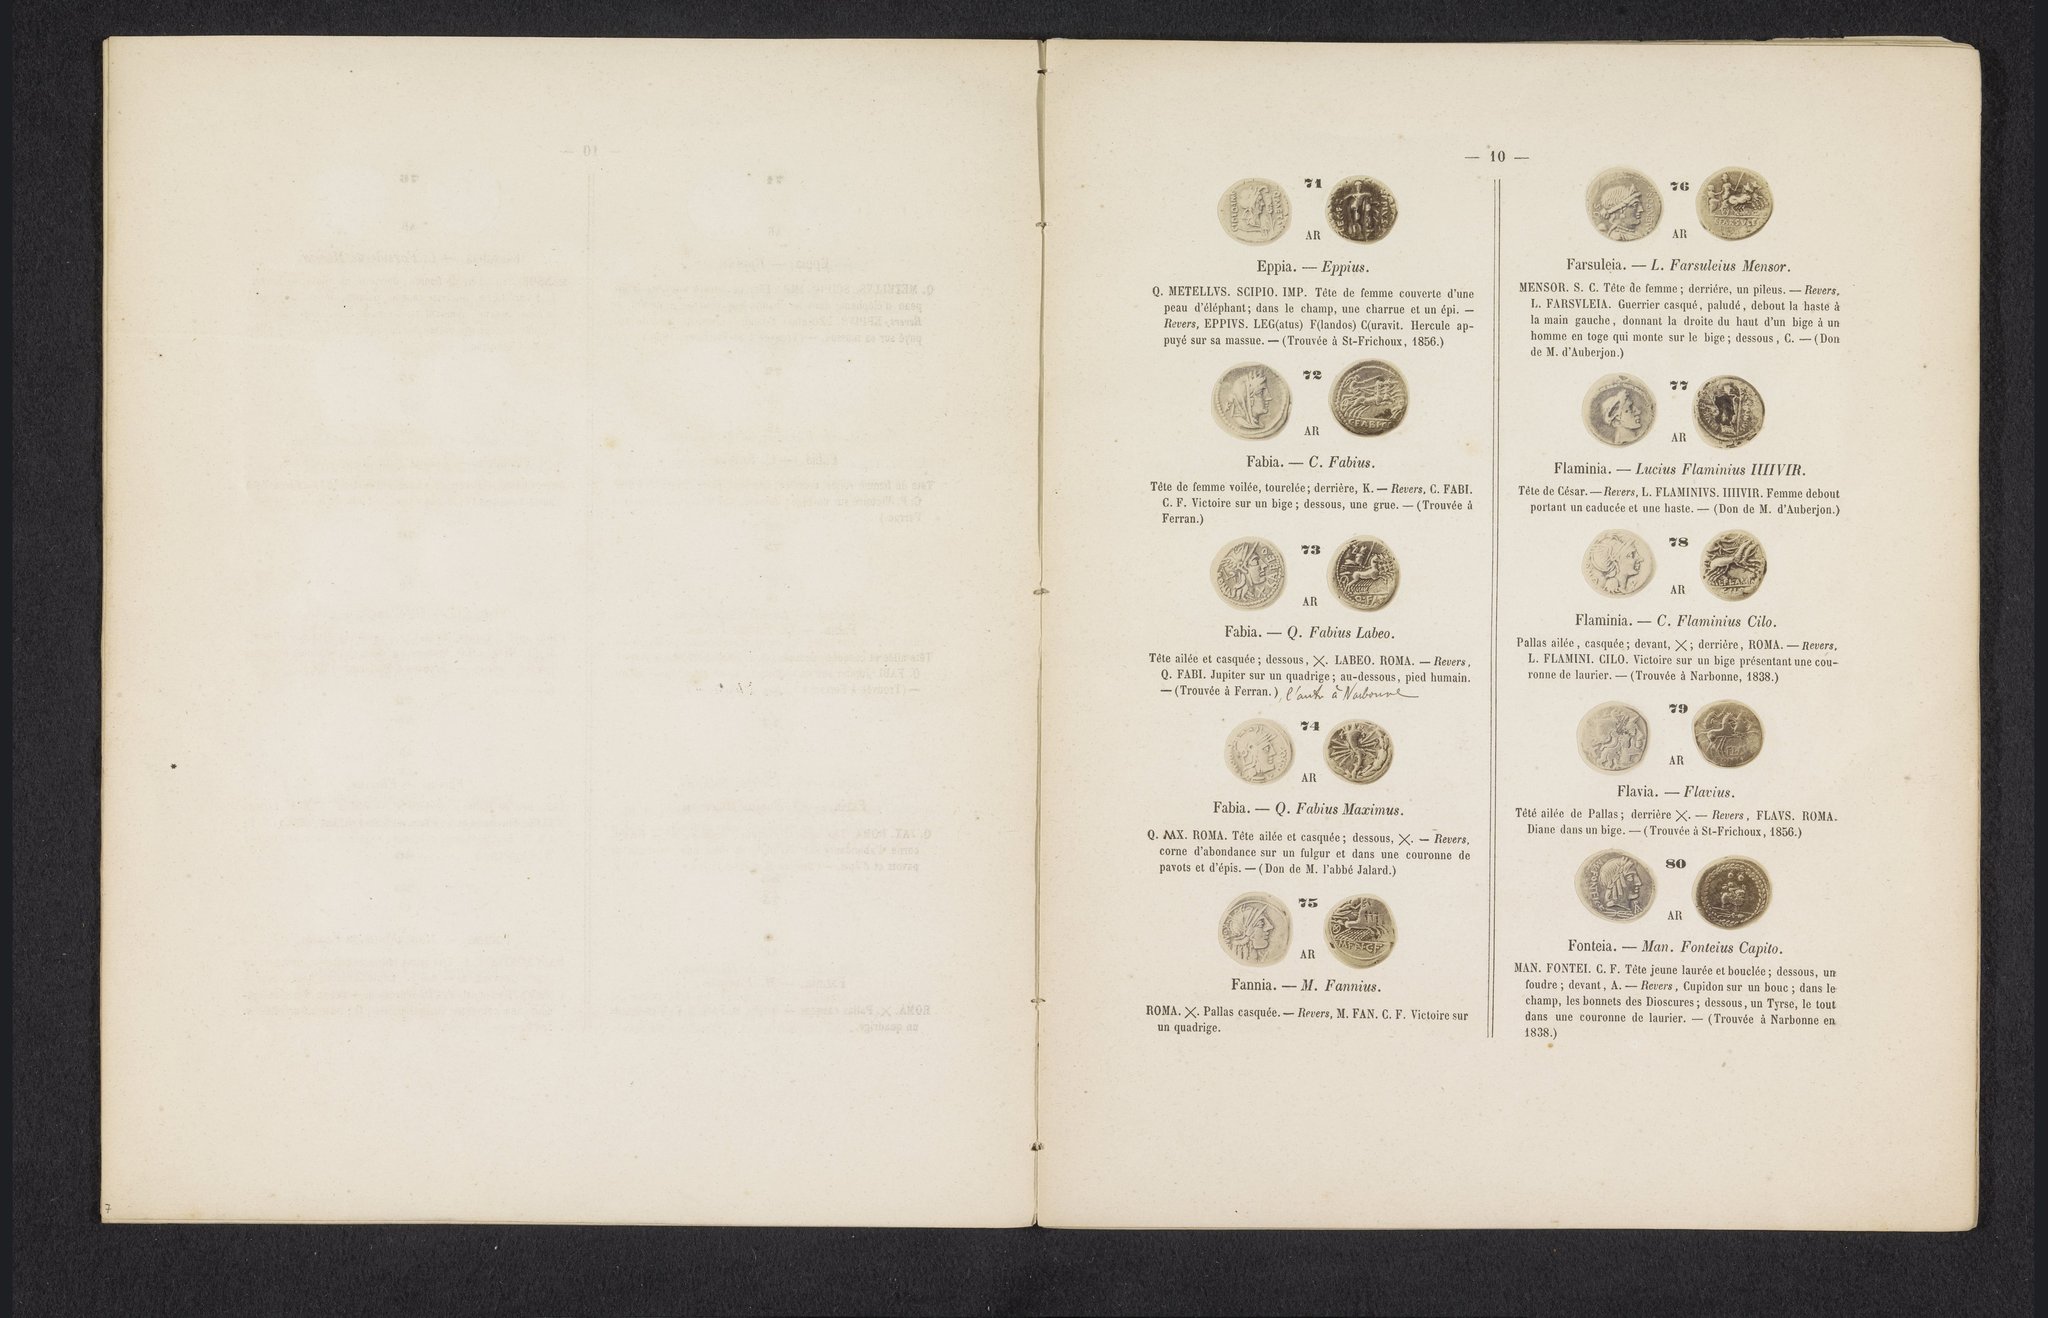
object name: photograph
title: Tien Romeinse munten, gezien van voor- en achterkant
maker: léopold verguet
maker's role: abt, fotograaf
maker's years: 1817-1914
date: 1854-1864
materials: photographic support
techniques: albumen print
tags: coin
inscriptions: number